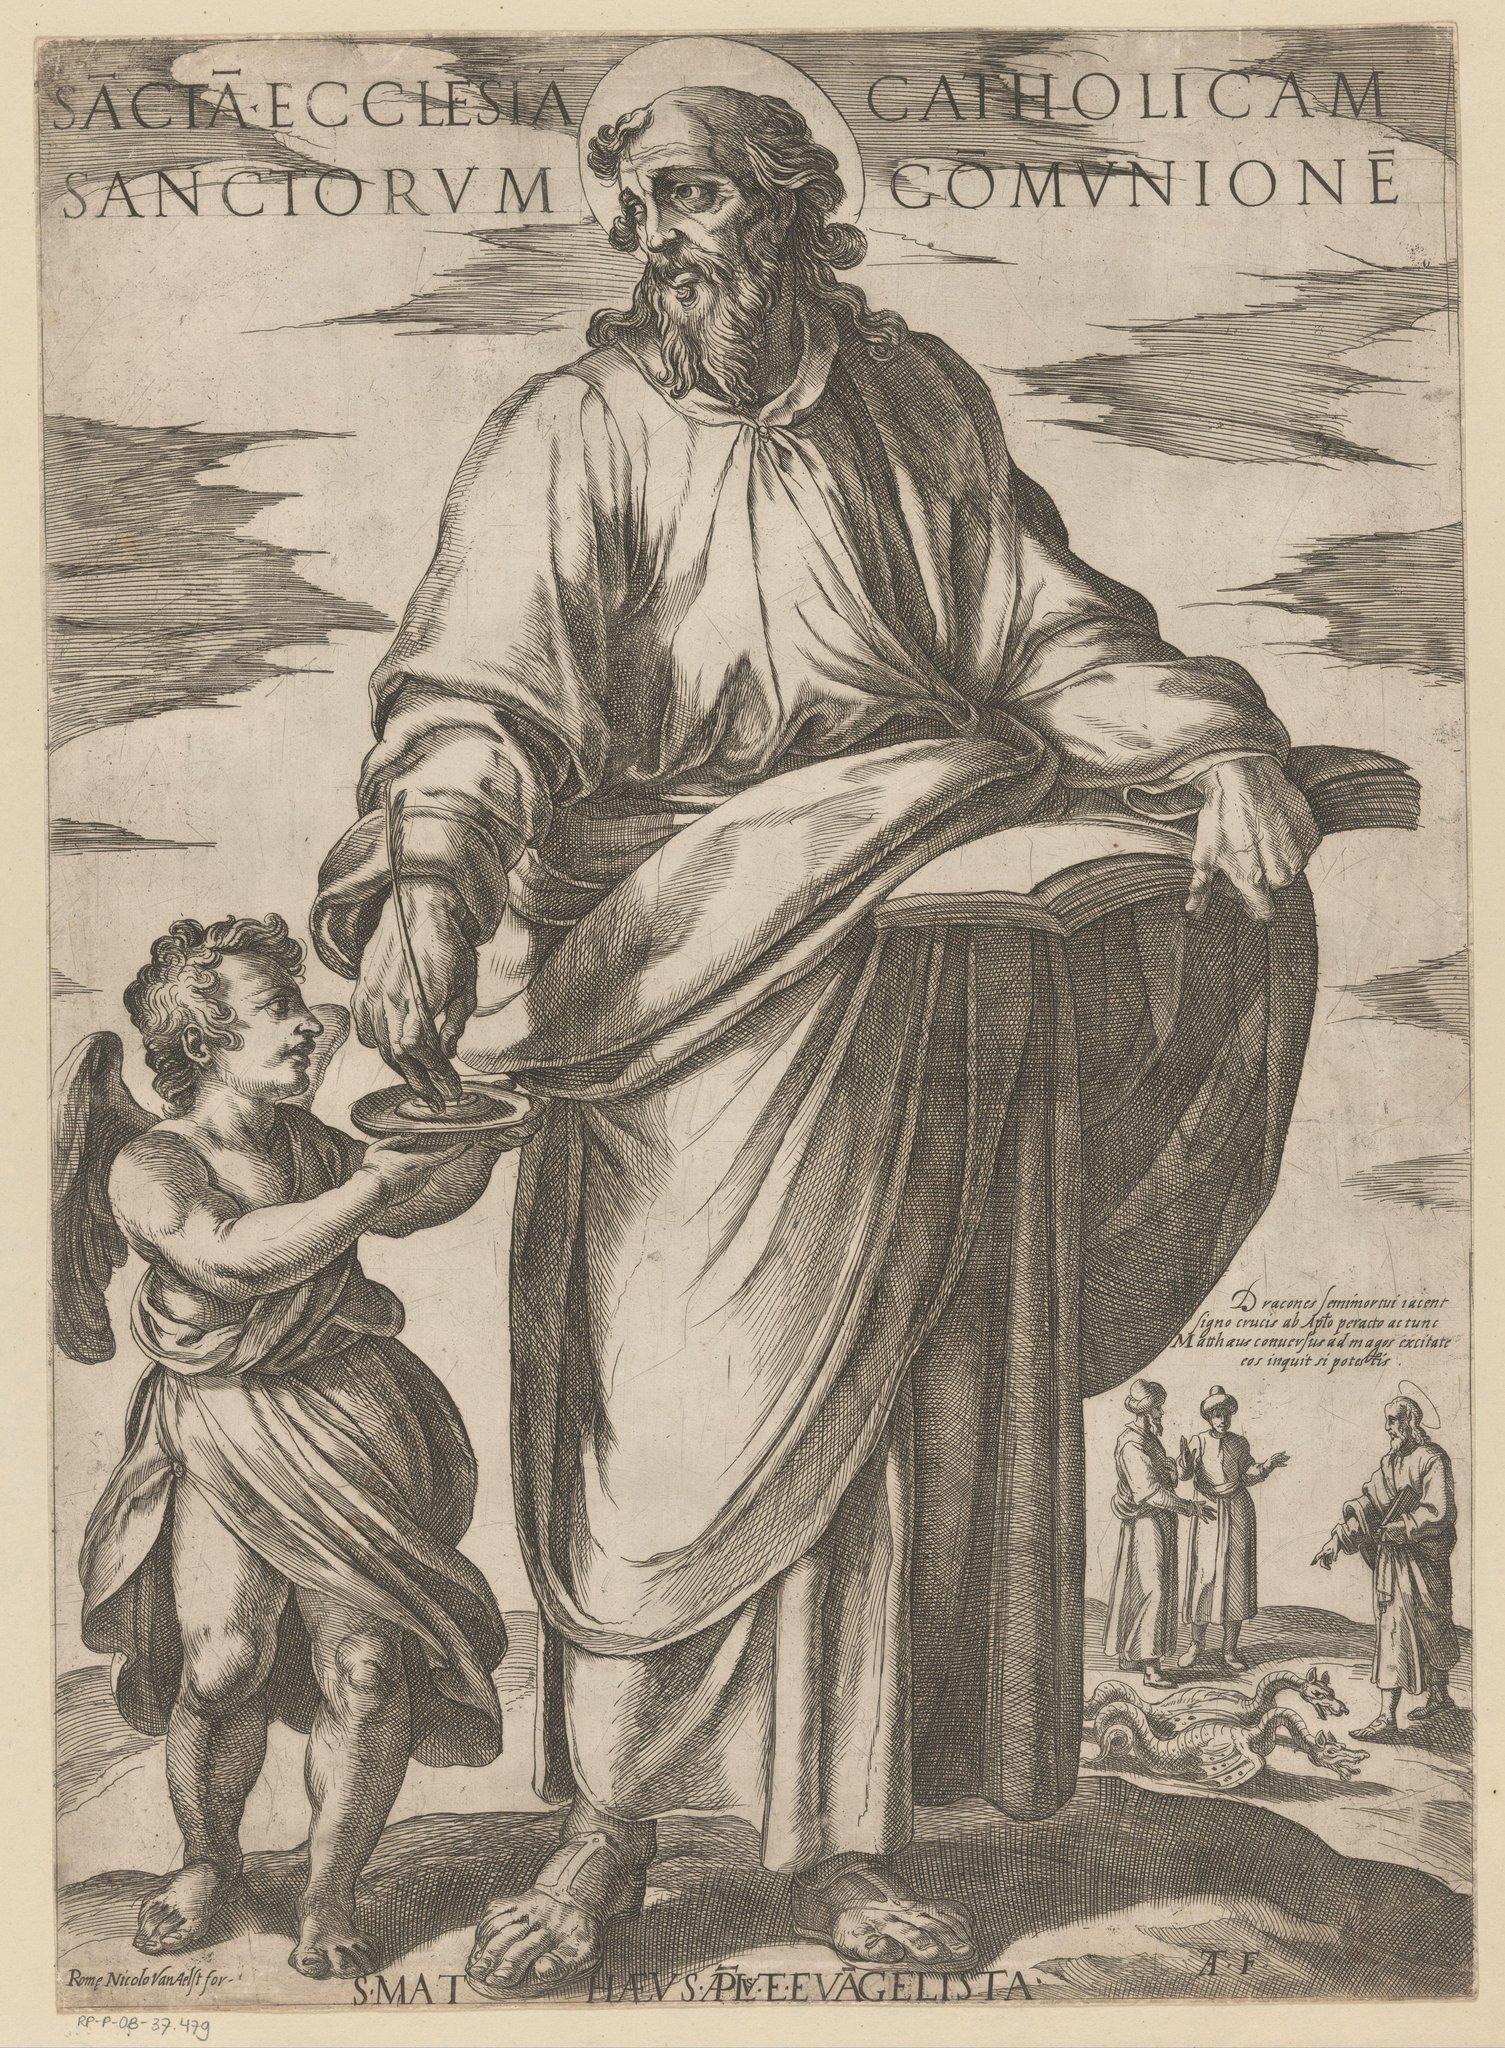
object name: print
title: De heilige Matteüs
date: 1565-1630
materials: paper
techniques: etching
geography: italy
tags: the apostle and evangelist matthew (mattheus); possible attributes: angel, axe, book, halberd, pen and inkhorn, purse, scroll, square, sword, matthew's victory over two dragons in vadabar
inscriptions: collector's mark: Lugt 240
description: De heilige Matteüs met boek, schrijfveer en engel met inktpot. Op de achtergrond rechts Matteüs die twee draken in Vadabar overwint.